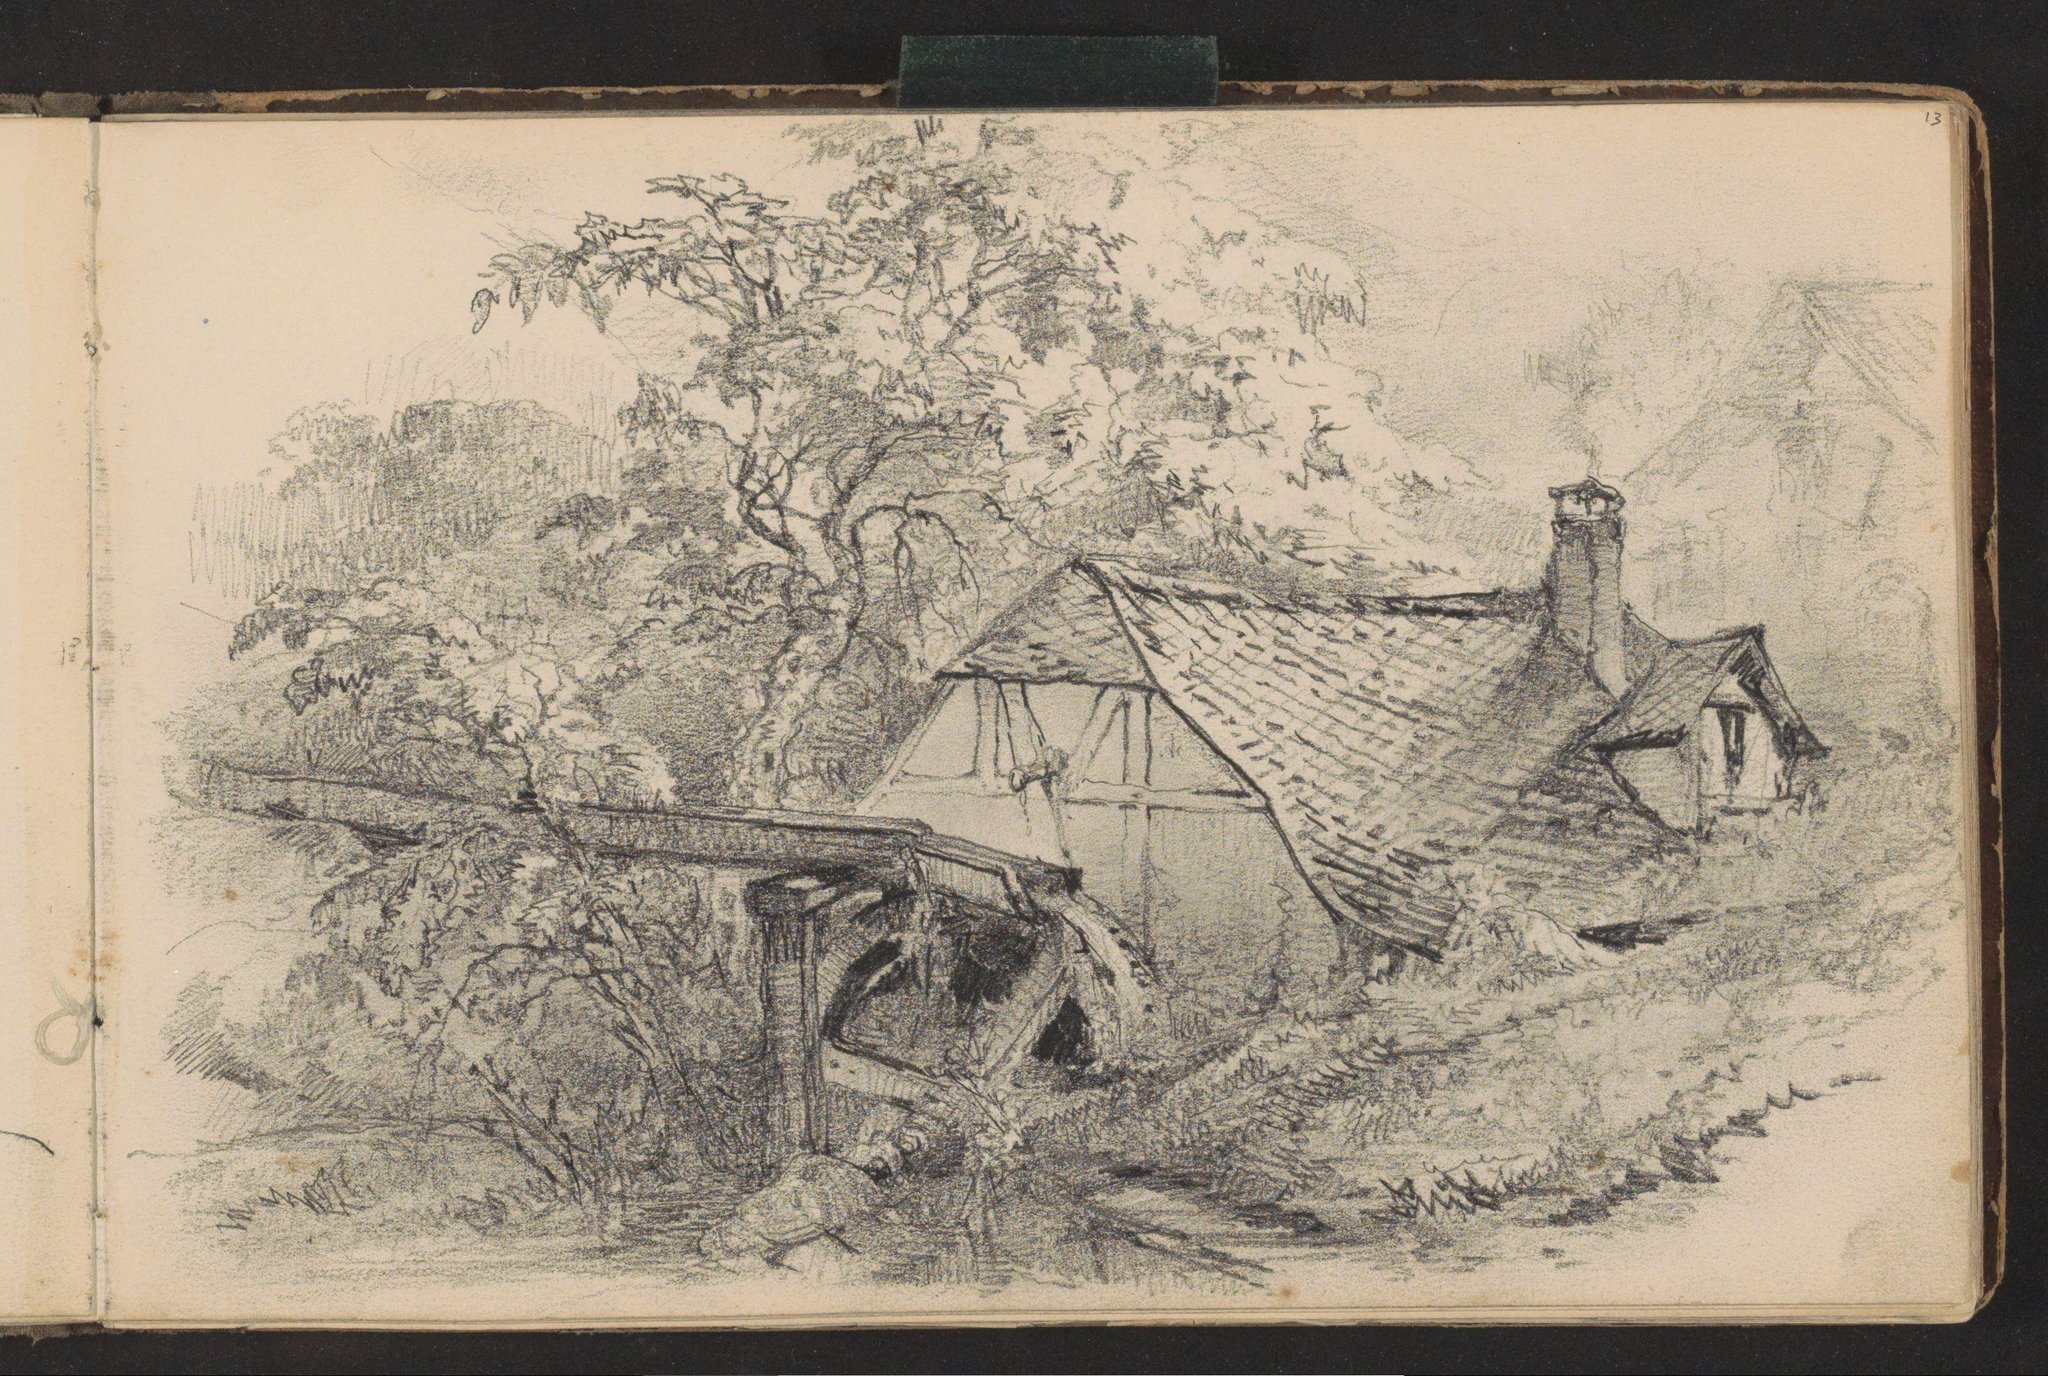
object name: sketchbook leaf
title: Vakwerkhuis met een waterrad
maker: maria vos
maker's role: draughtsman, painter, print maker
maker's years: 1824-1906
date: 1871-1878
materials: paper, pencil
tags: paddle wheel, rural housing, e.g. country-house, villa, cottage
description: Blad 13 recto uit een schetsboek met 45 bladen.